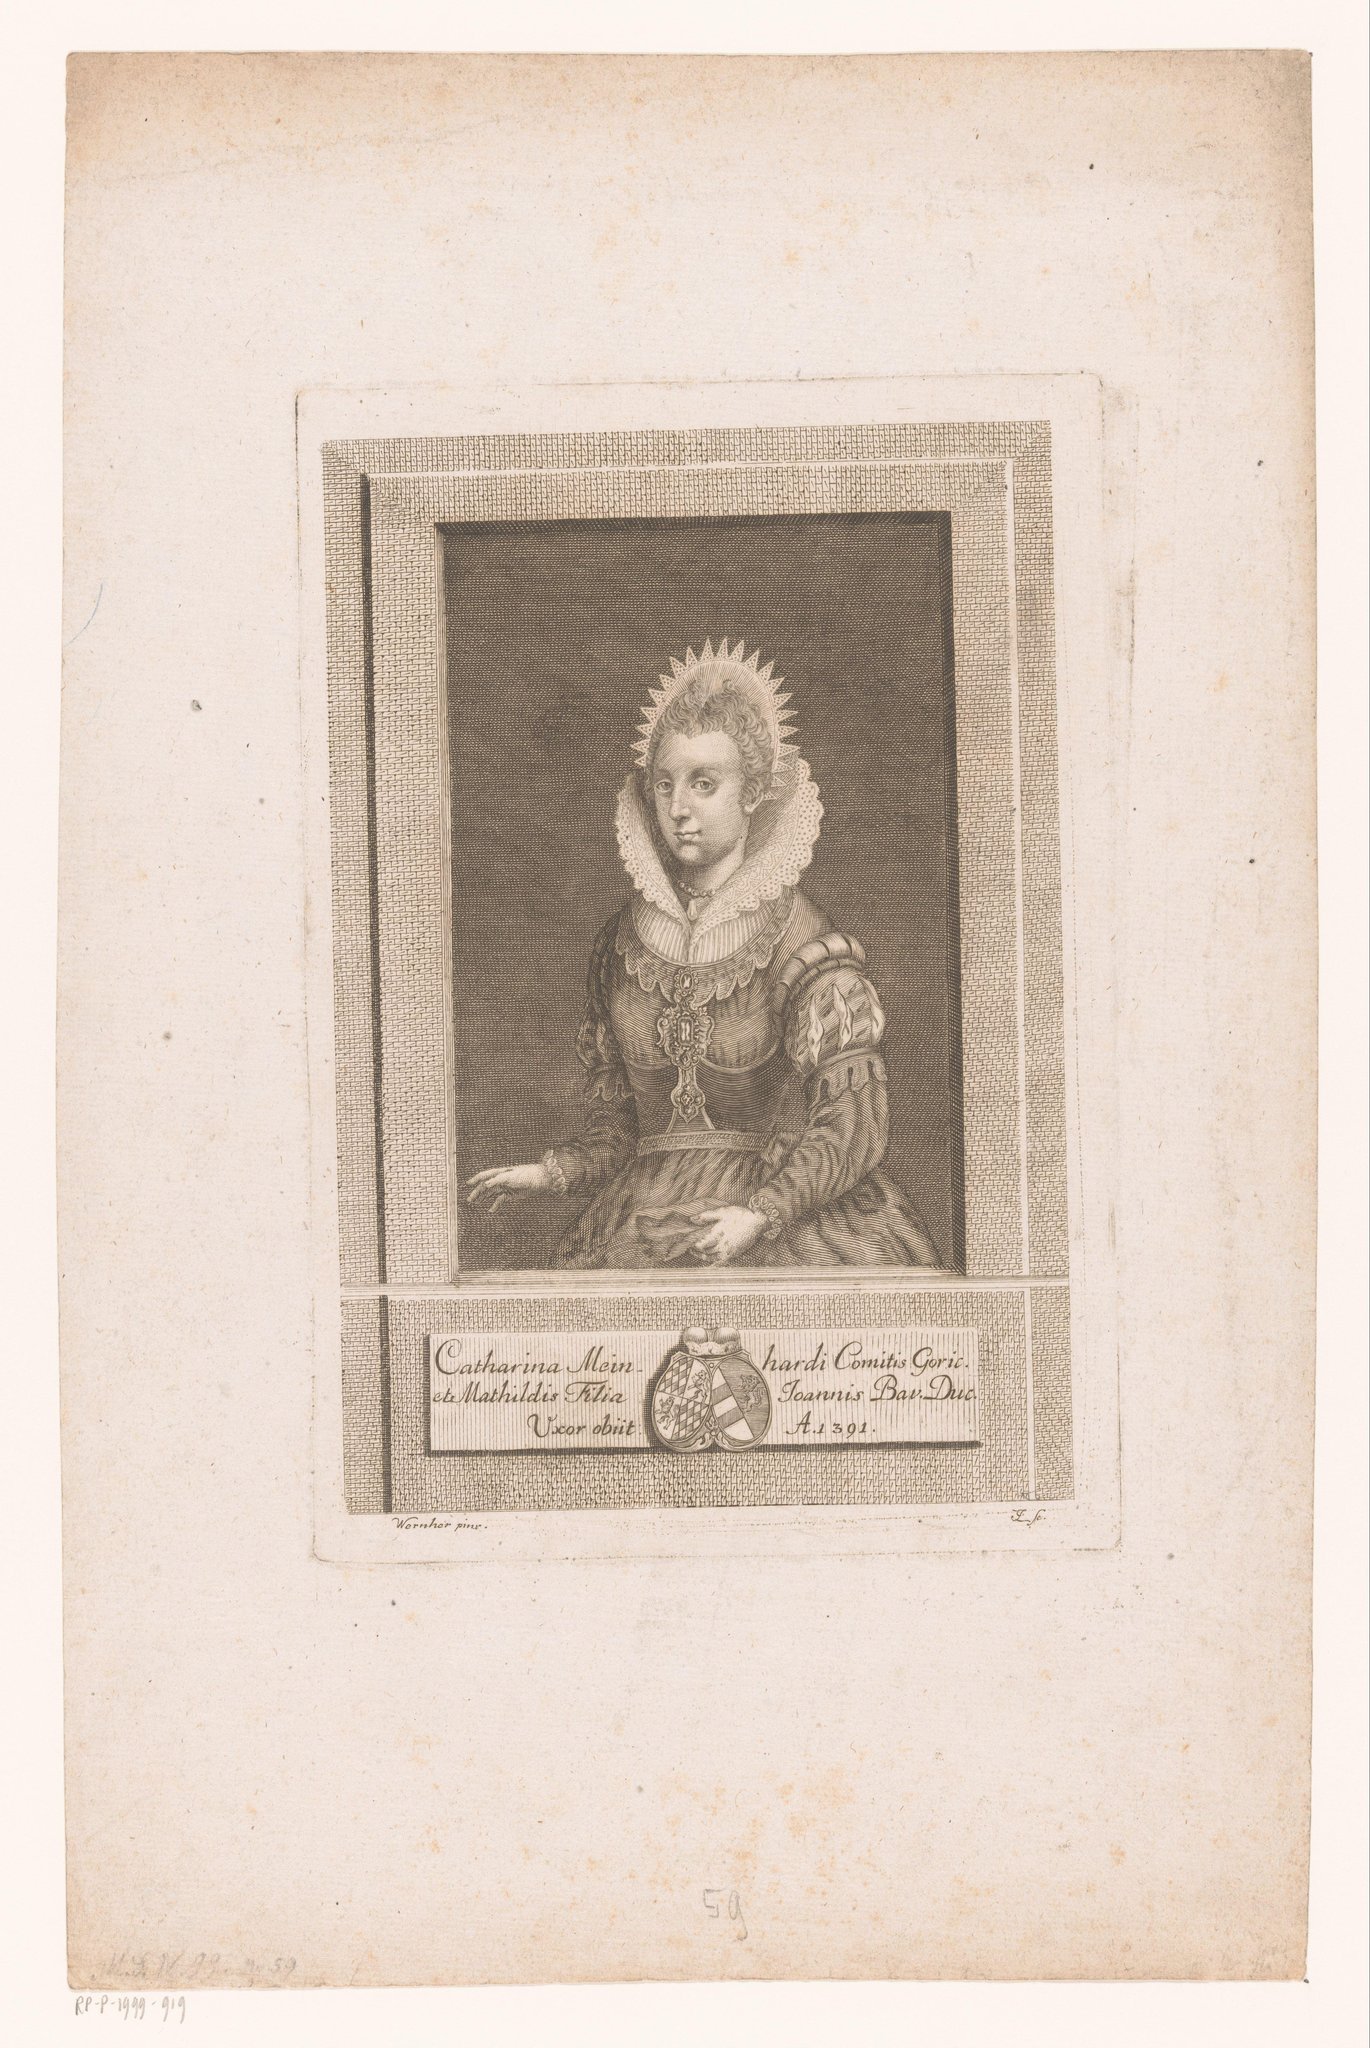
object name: print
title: Portret van Catharina van Gorizia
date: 1773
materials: paper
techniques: engraving, etching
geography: germany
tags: historical persons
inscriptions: collector's mark: Lugt 2228, collector's mark: Lugt 4100, collector's mark: Lugt 2760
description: Prent gebruikt voor de publicatie: Zimmermann, Joseph Anton. Series Imaginum Augustae Domus Boicae. München: s.n., 1773.